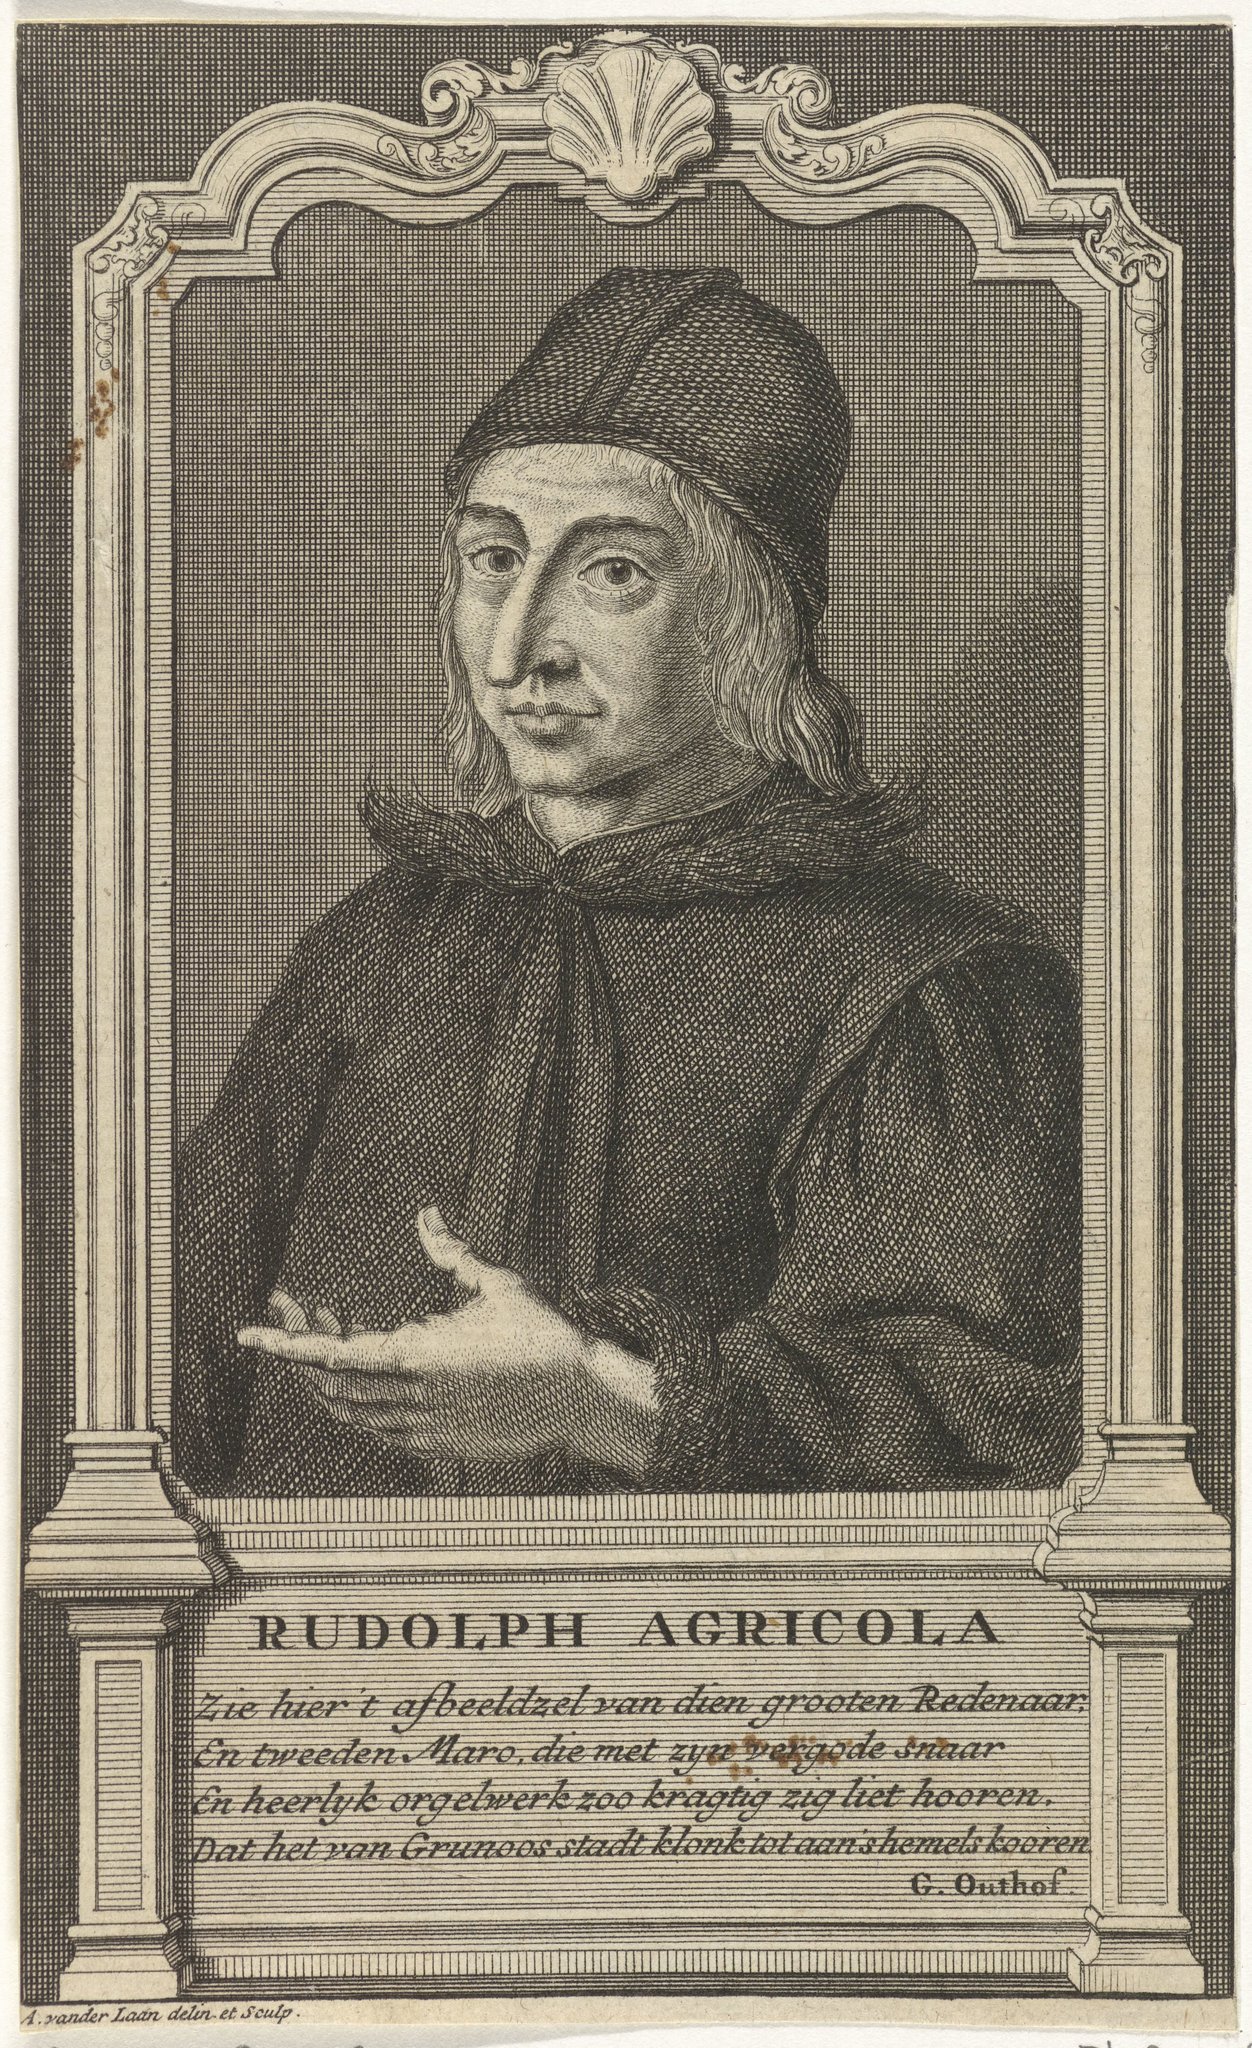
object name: print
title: Portret Rudolf van Agricola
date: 1694-1755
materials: paper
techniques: engraving, etching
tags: heidelberg, schrijver, rudolf agricola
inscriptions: collector's mark: Lugt 2228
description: Portretbuste naar links van Rudolf van Agricola, kerkhervormer en Latijns taalgeleerde, met hoofddeksel. Rondom een ornamentele omlijsting, onder het portret de naam van de geportretteerde en een vierregelig Nederlands vers.